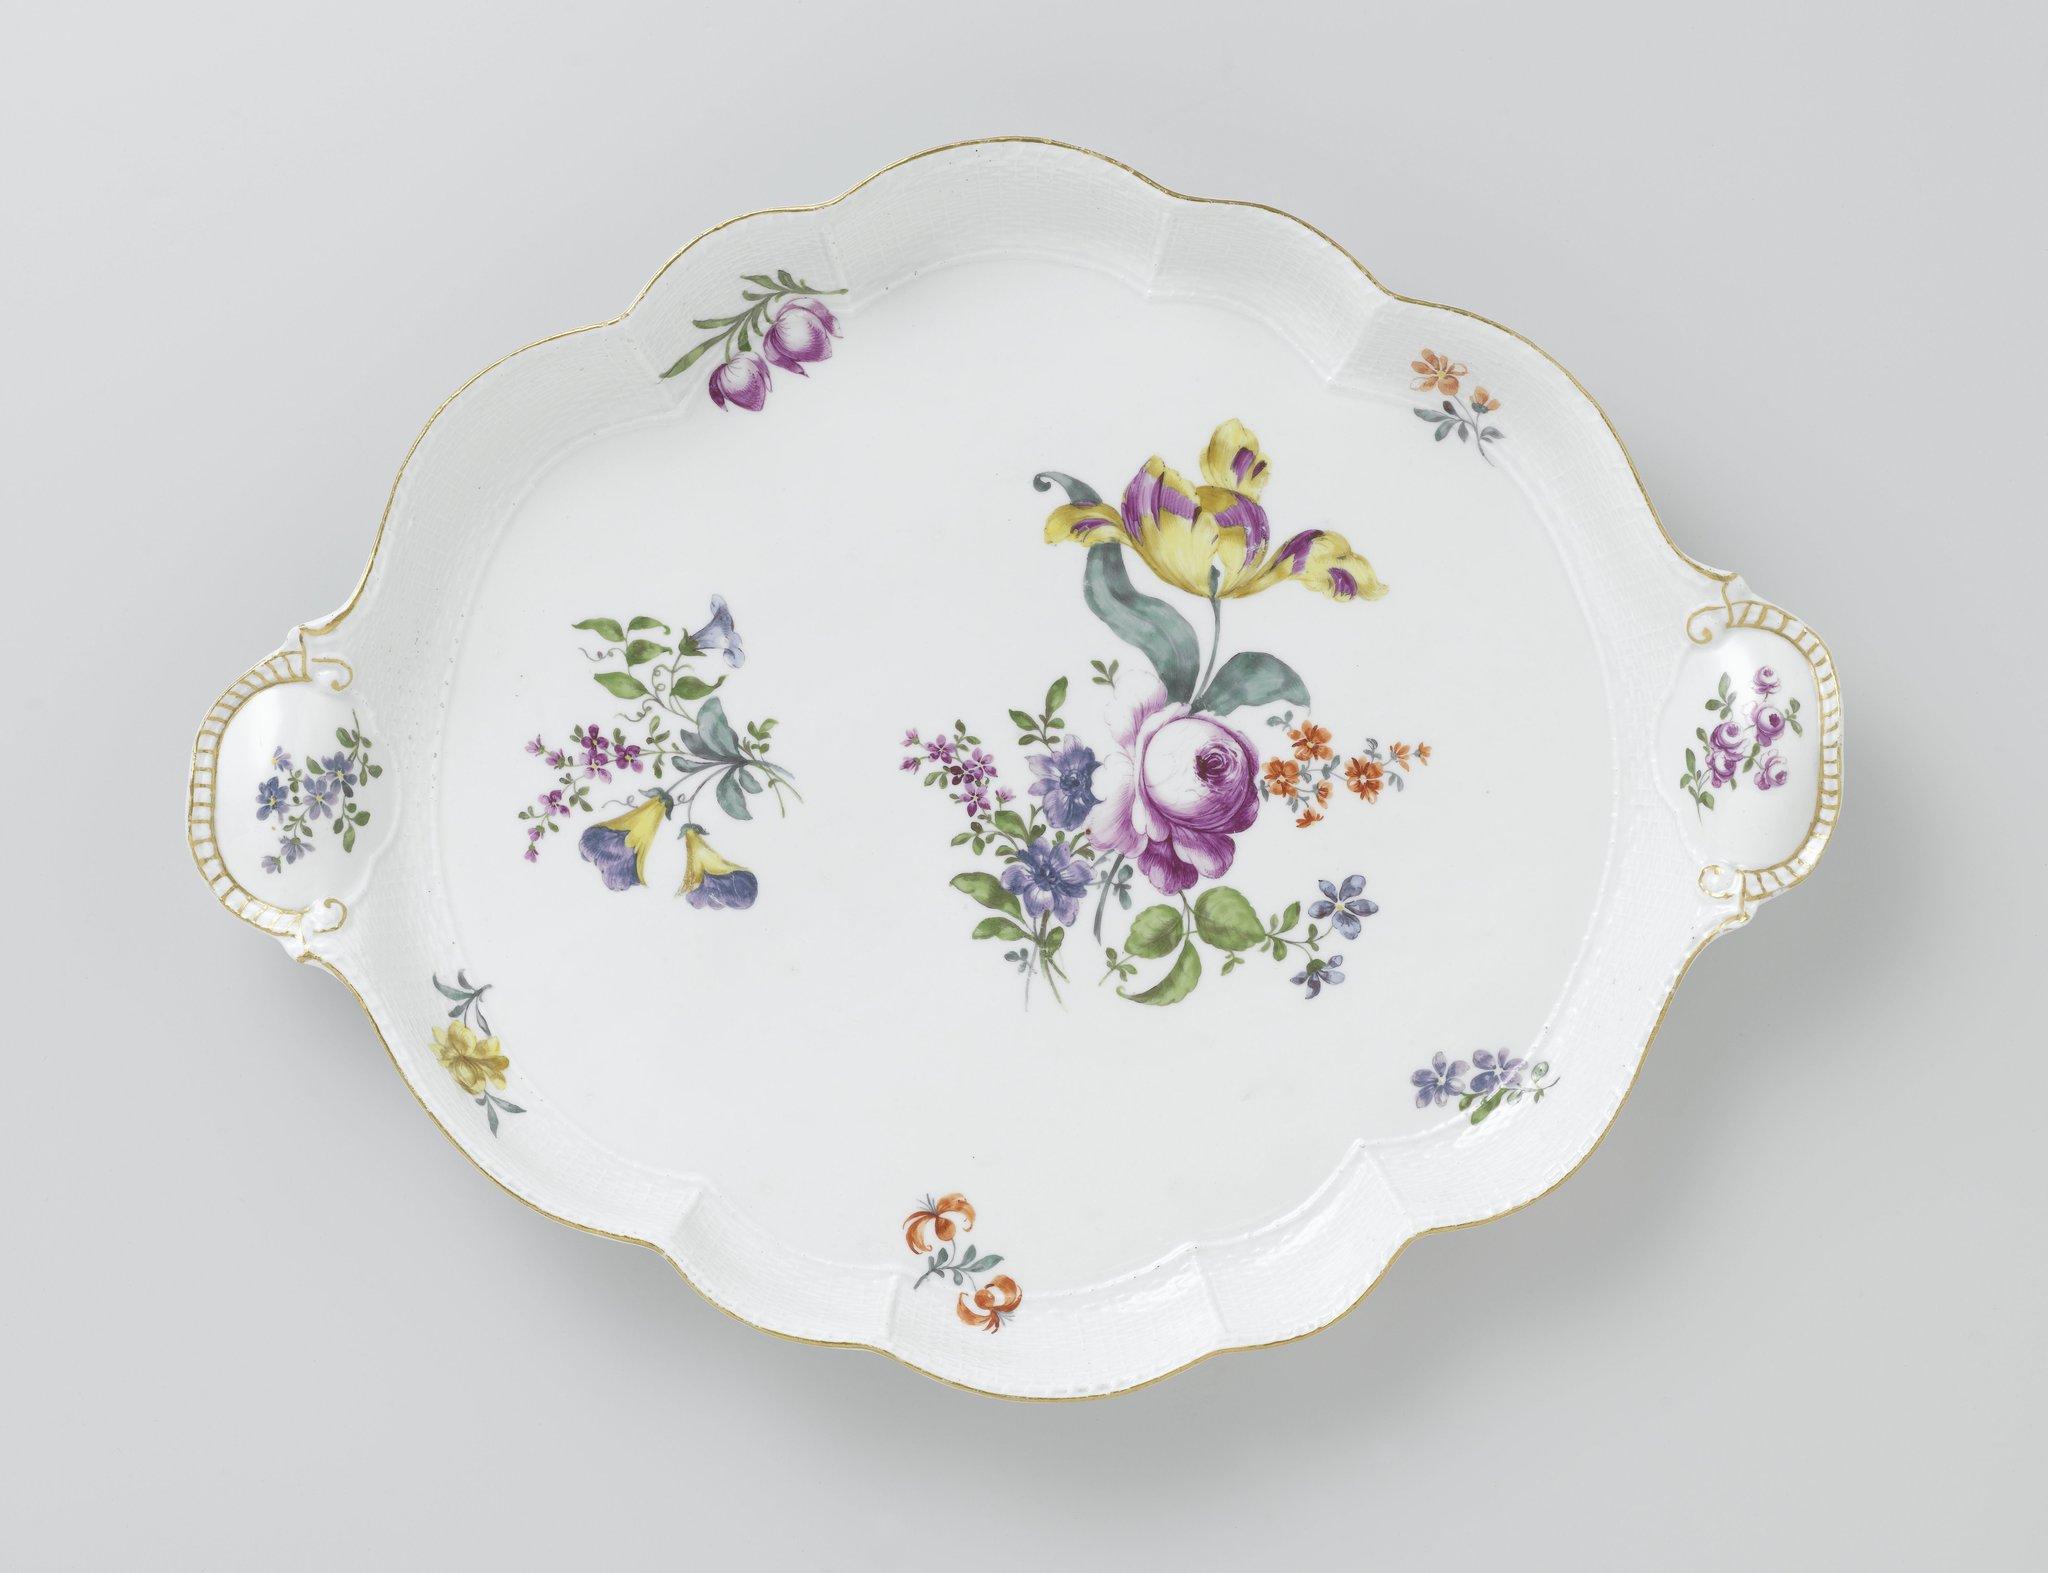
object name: eating drinking utensil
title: Schotel, veelkleurig beschilderd met Deutsche Blumen, insekten en vruchten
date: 1750-1760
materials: porcelain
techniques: painted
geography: meissen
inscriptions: factory mark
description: Ovale schotel van beschilderd porselein, met een hoge opstaande geschulpte rand, versierd met het Neuozier-patroon in reliëf. Twee vlak naar buiten springende gedeelten van de rand vormen de oren; deze zijn gewelfd en afgezet met een gouden blokrand. De schotel is beschilderd met Deutsche Blumen, insekten en vruchten. De schotel is gemerkt en hoort bij een servies (BK-17474-1 t/m BK-17474-253).